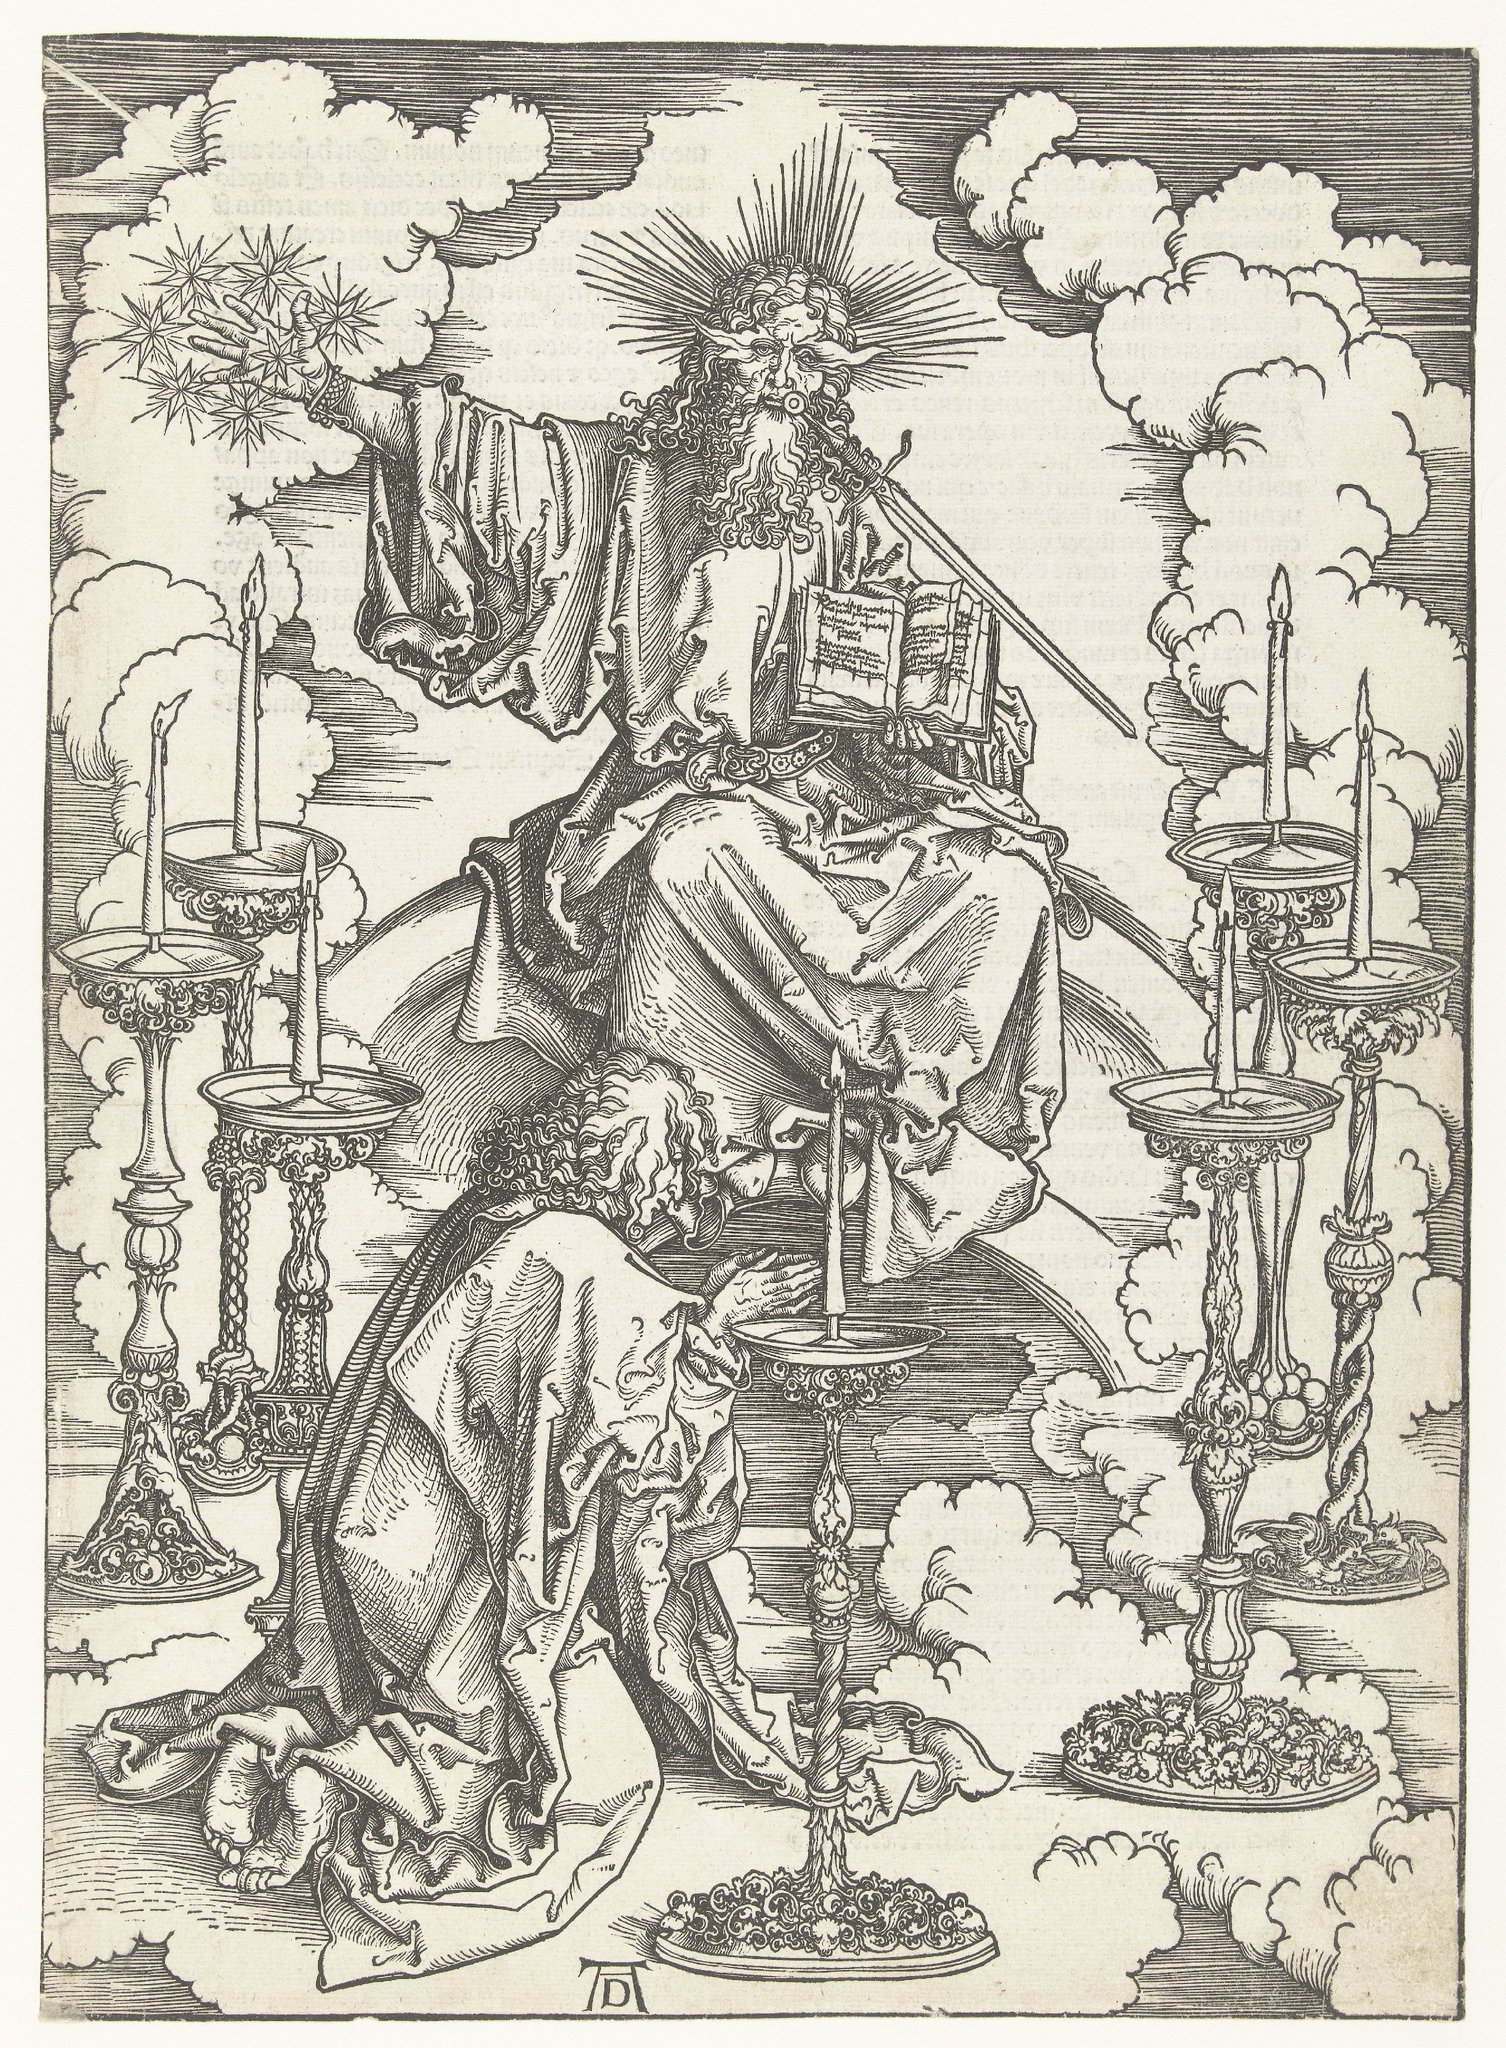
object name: print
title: Johannes de Evangelist knielt voor Christus temidden van zeven kandelaars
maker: albrecht dürer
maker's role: draughtsman, painter, print maker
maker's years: 1471-1528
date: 1496-1498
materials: paper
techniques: letterpress printing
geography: nuremberg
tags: christ between seven golden candlesticks appears to john, who falls to the ground; a sword comes out of christ's mouth and he holds seven stars in his hands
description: Johannes knielt voor Christus, die troont temidden van zeven kandelaars, een zwaard bij zijn mond, zeven sterren bij zijn rechterhand en een boek in zijn linkerhand. Op versozijde Latijnse bijbeltekst in gotisch schrift in twee kolommen.